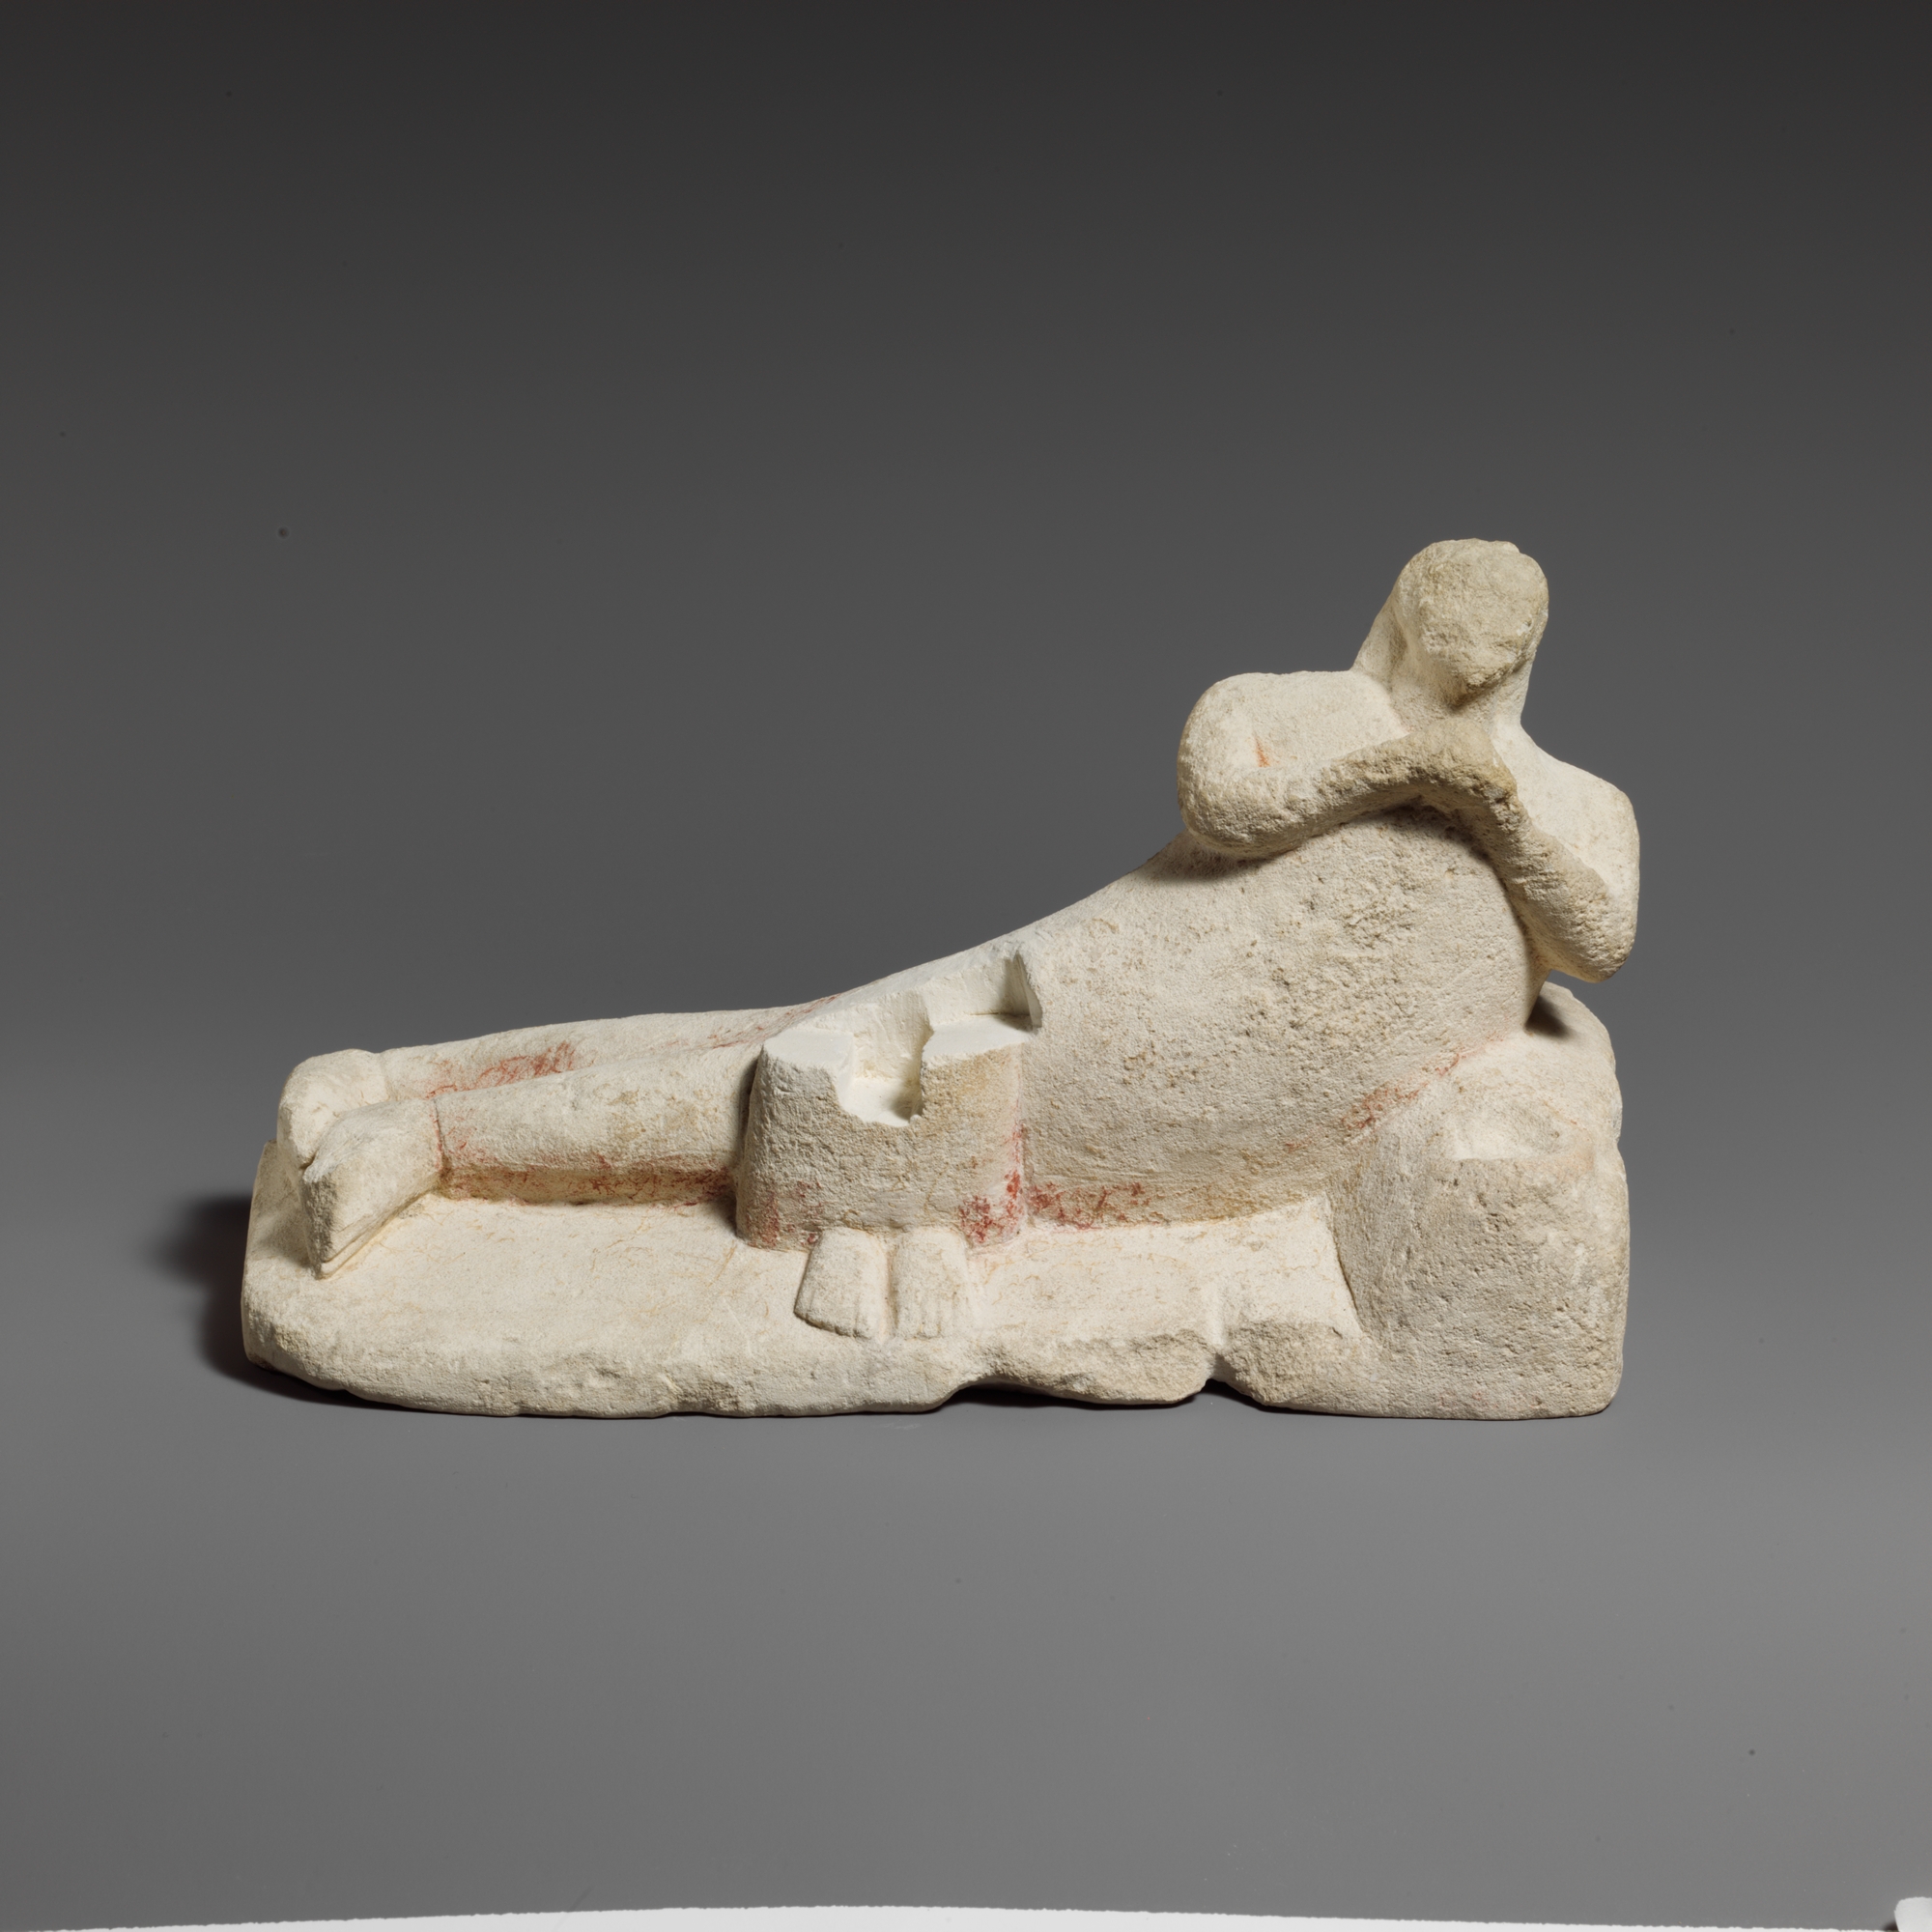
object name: statue of a votary, female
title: Limestone group of a male banqueter and a woman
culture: cypriot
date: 600-501 BCE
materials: limestone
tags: men,women